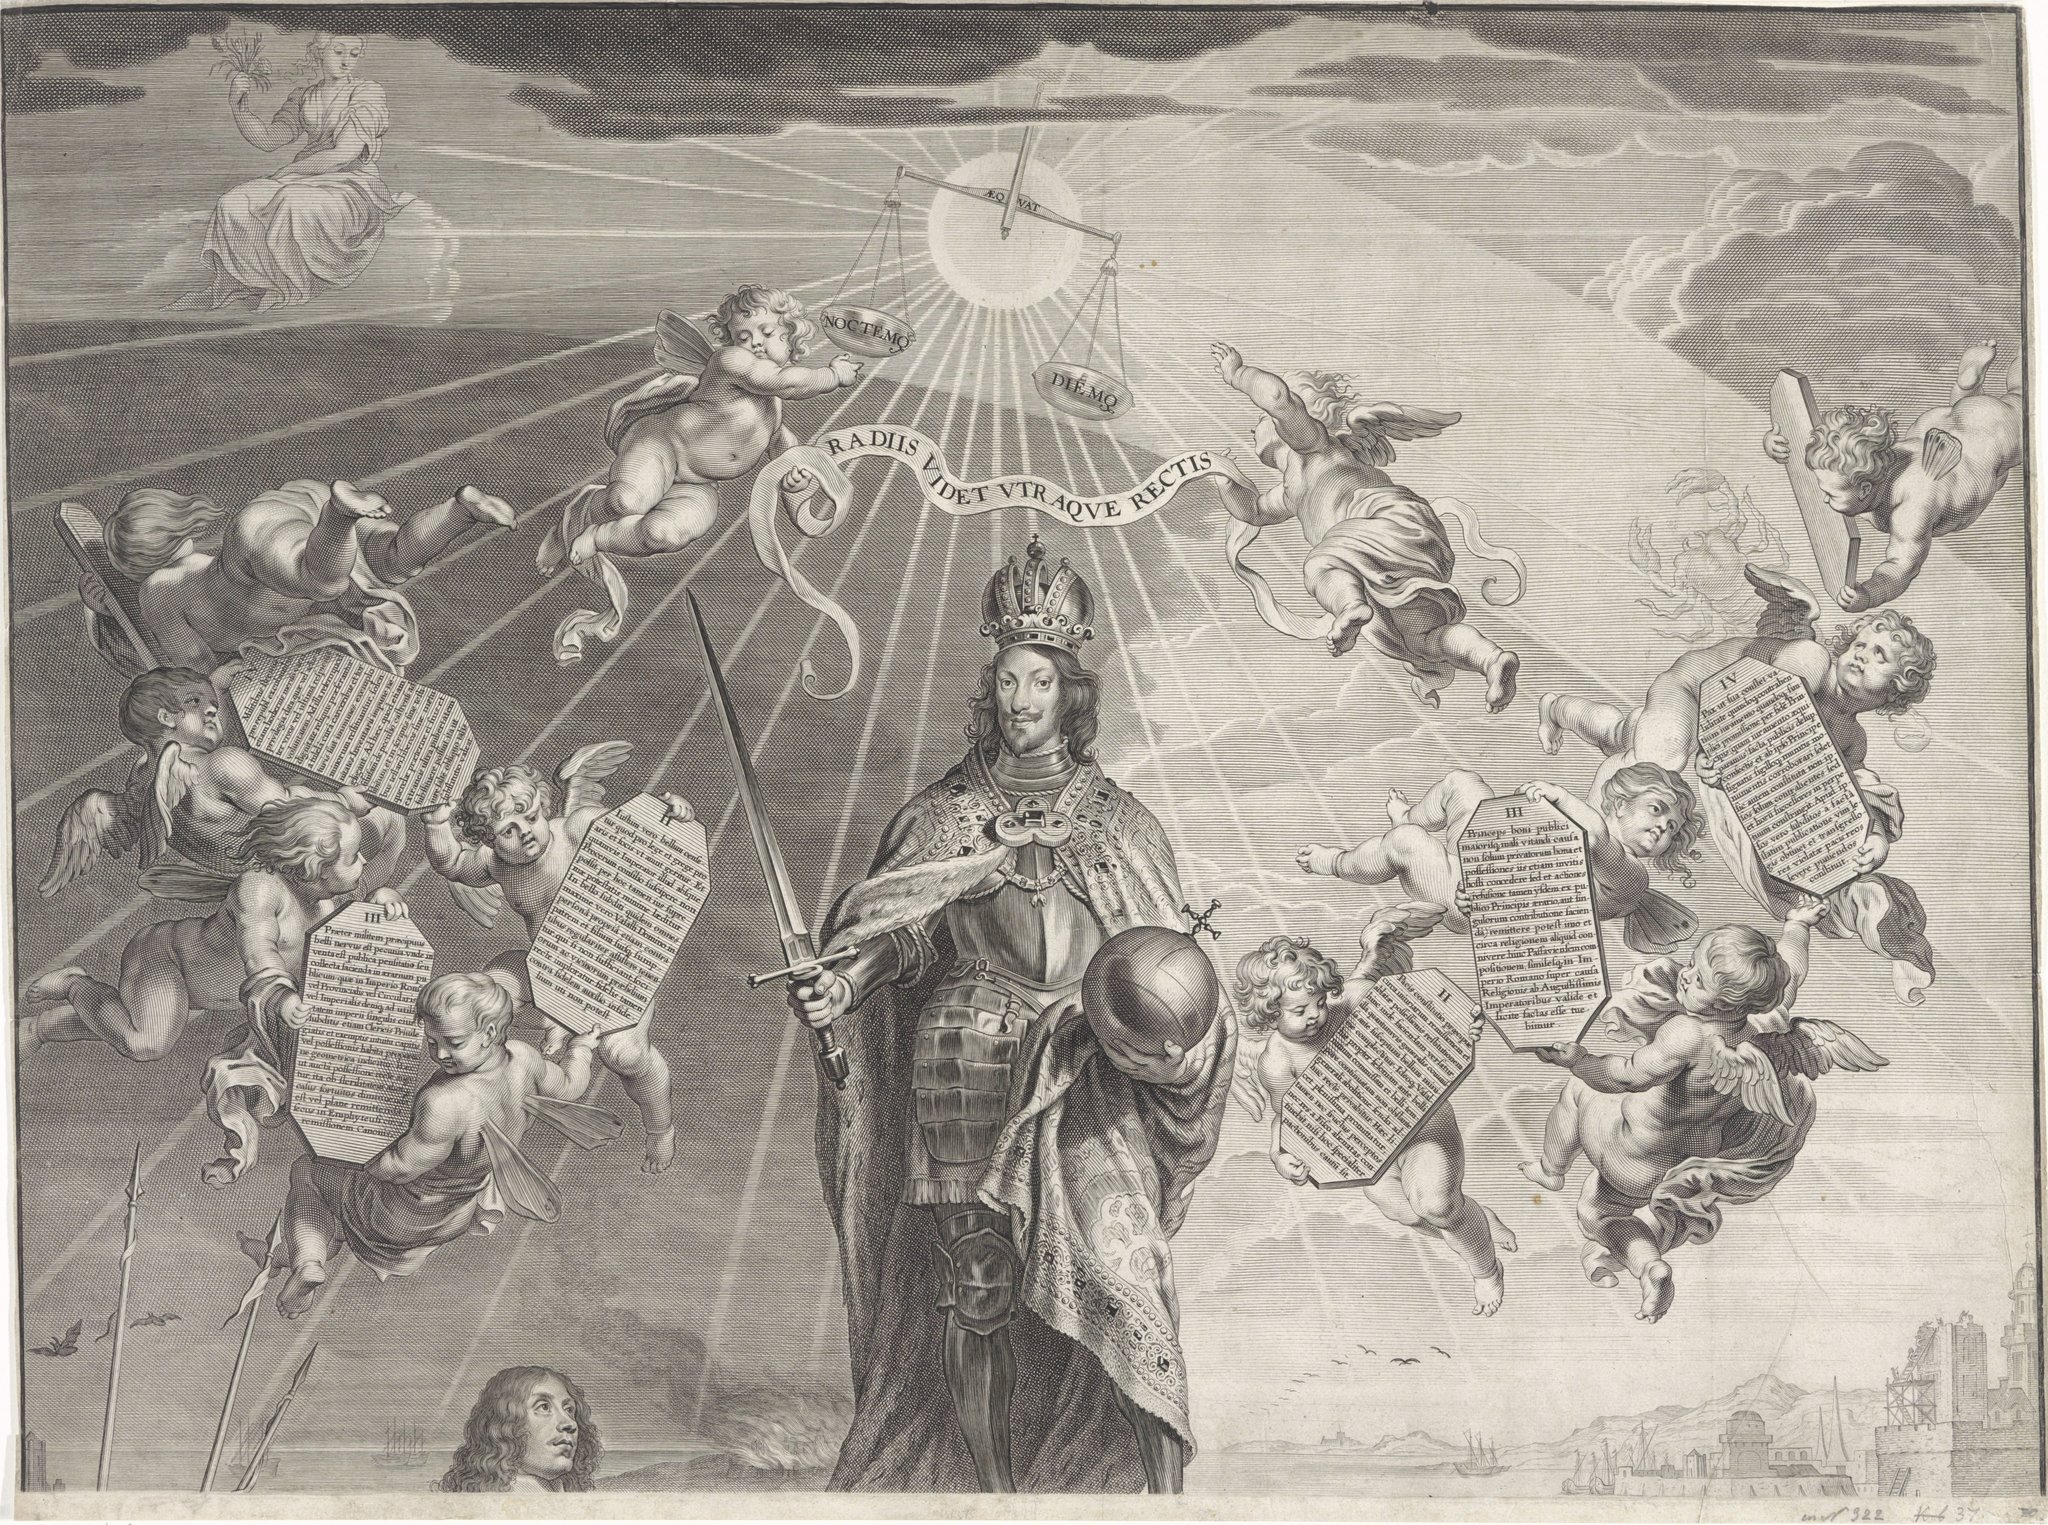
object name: print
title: Portret van keizer Ferdinand III met een allegorie op de oorlog en de vrede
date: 1645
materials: paper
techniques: engraving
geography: antwerp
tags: vienna, ferdinand iii (duits keizer), war and peace, cupids: 'amores', 'amoretti', 'putti'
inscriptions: collector's mark: Lugt 240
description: Bovenste gedeelte van een voorstelling met het portret van Duits keizer Ferdinand III met een allegorie op de oorlog en de vrede. Ferdinand III, Duits keizer, met een zwaard in zijn ene hand en een rijksappel in de andere hand. Rond zijn portret een allegorische voorstelling op de oorlog en de vrede. In de lucht vliegen putti met stenen tafelen, waarin wetten zijn gebeiteld. Twee putti wijzen naar een weegschaal op de zon, die van dag naar nacht kan omslaan.